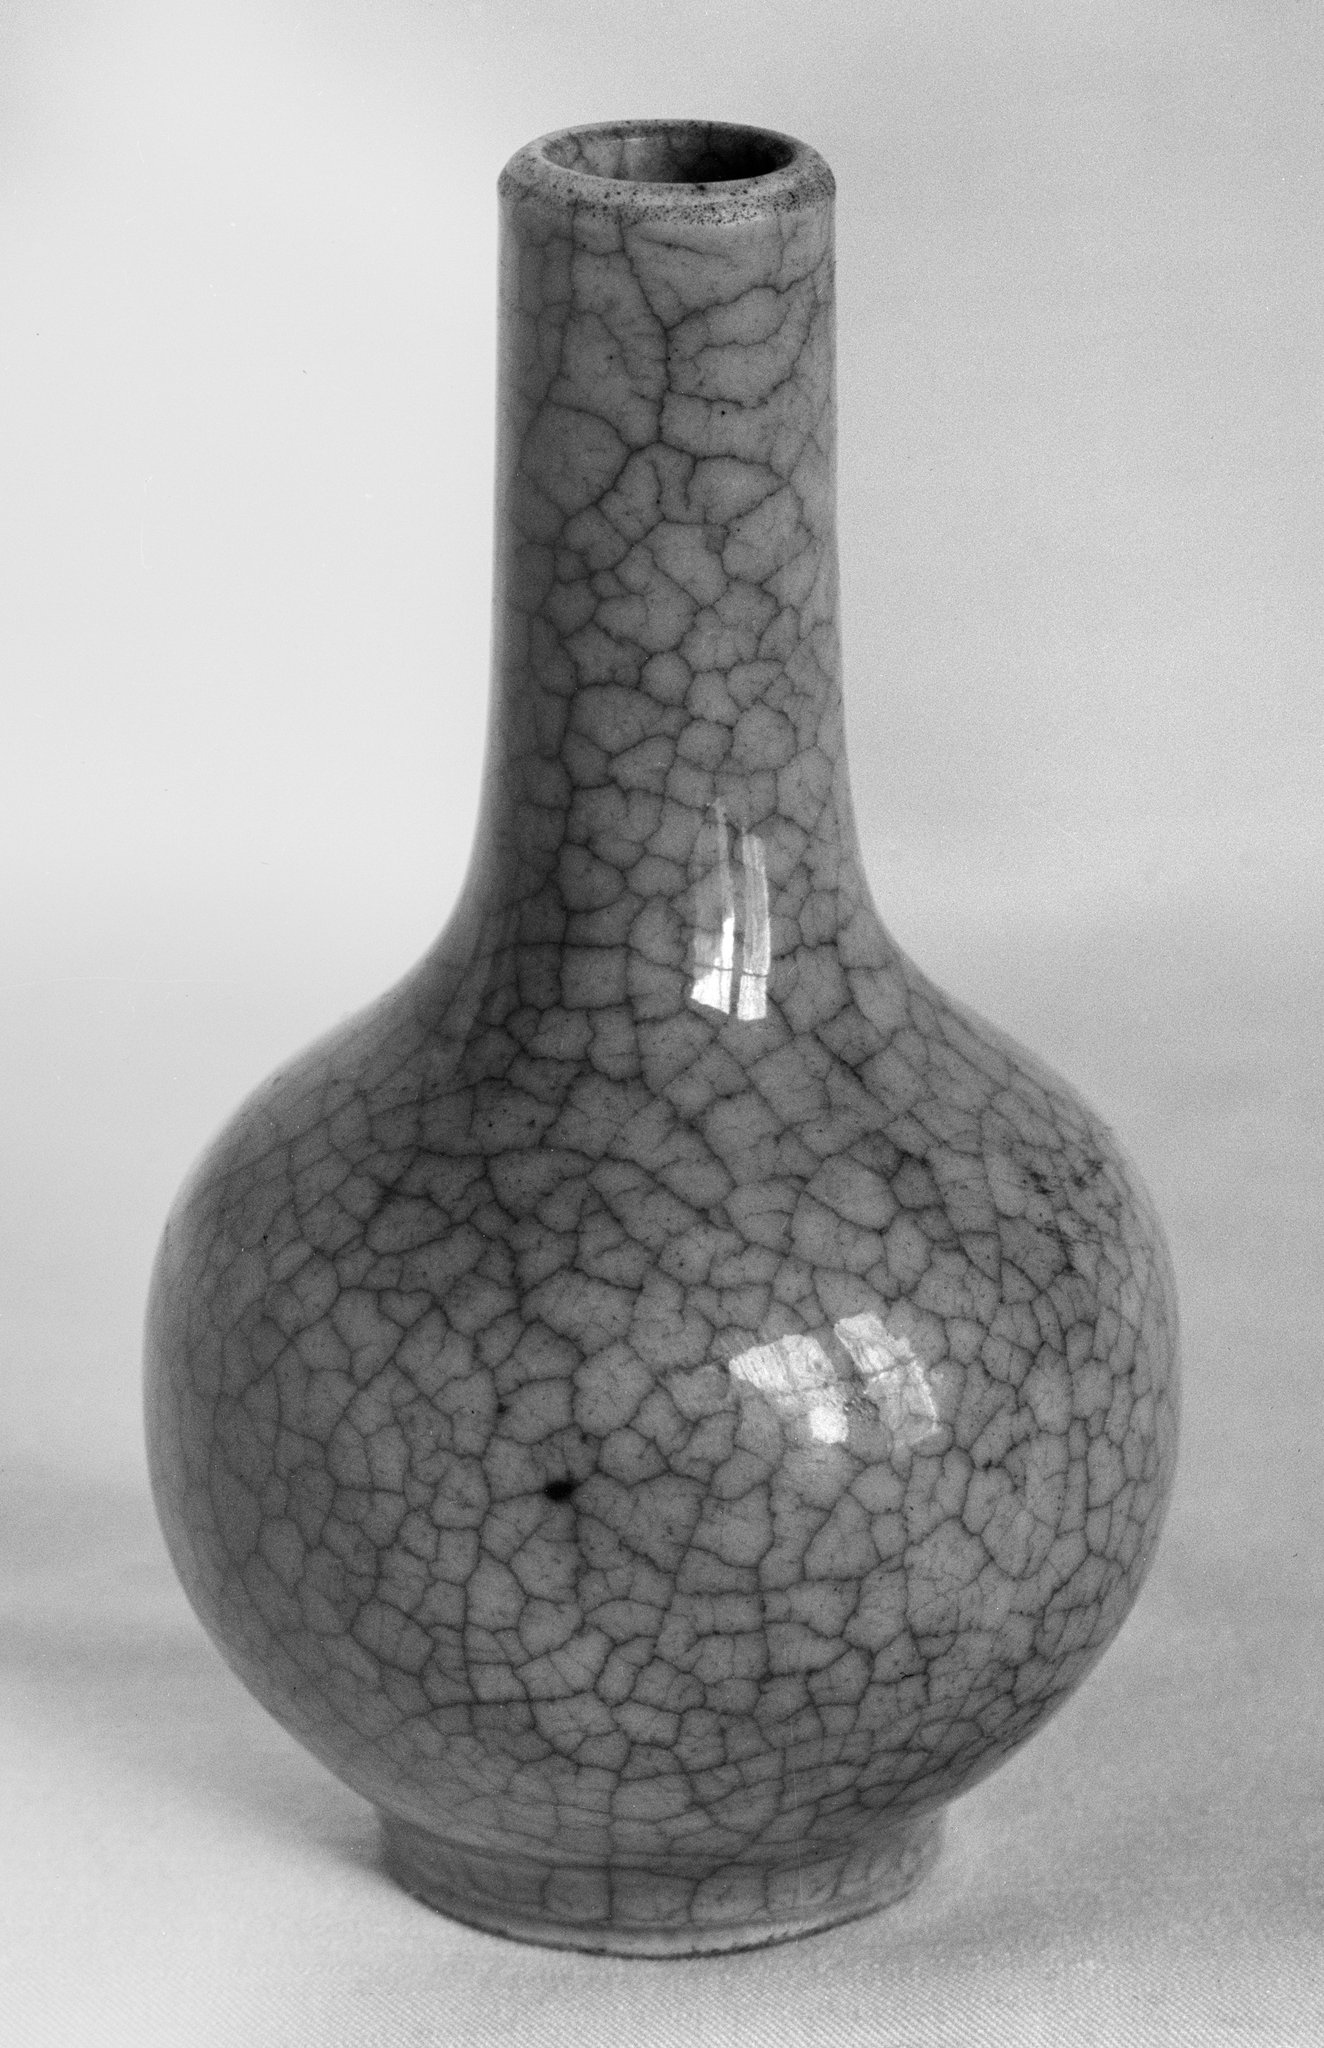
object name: bottle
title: Miniature Bottle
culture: chinese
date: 1662-1722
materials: porcelain